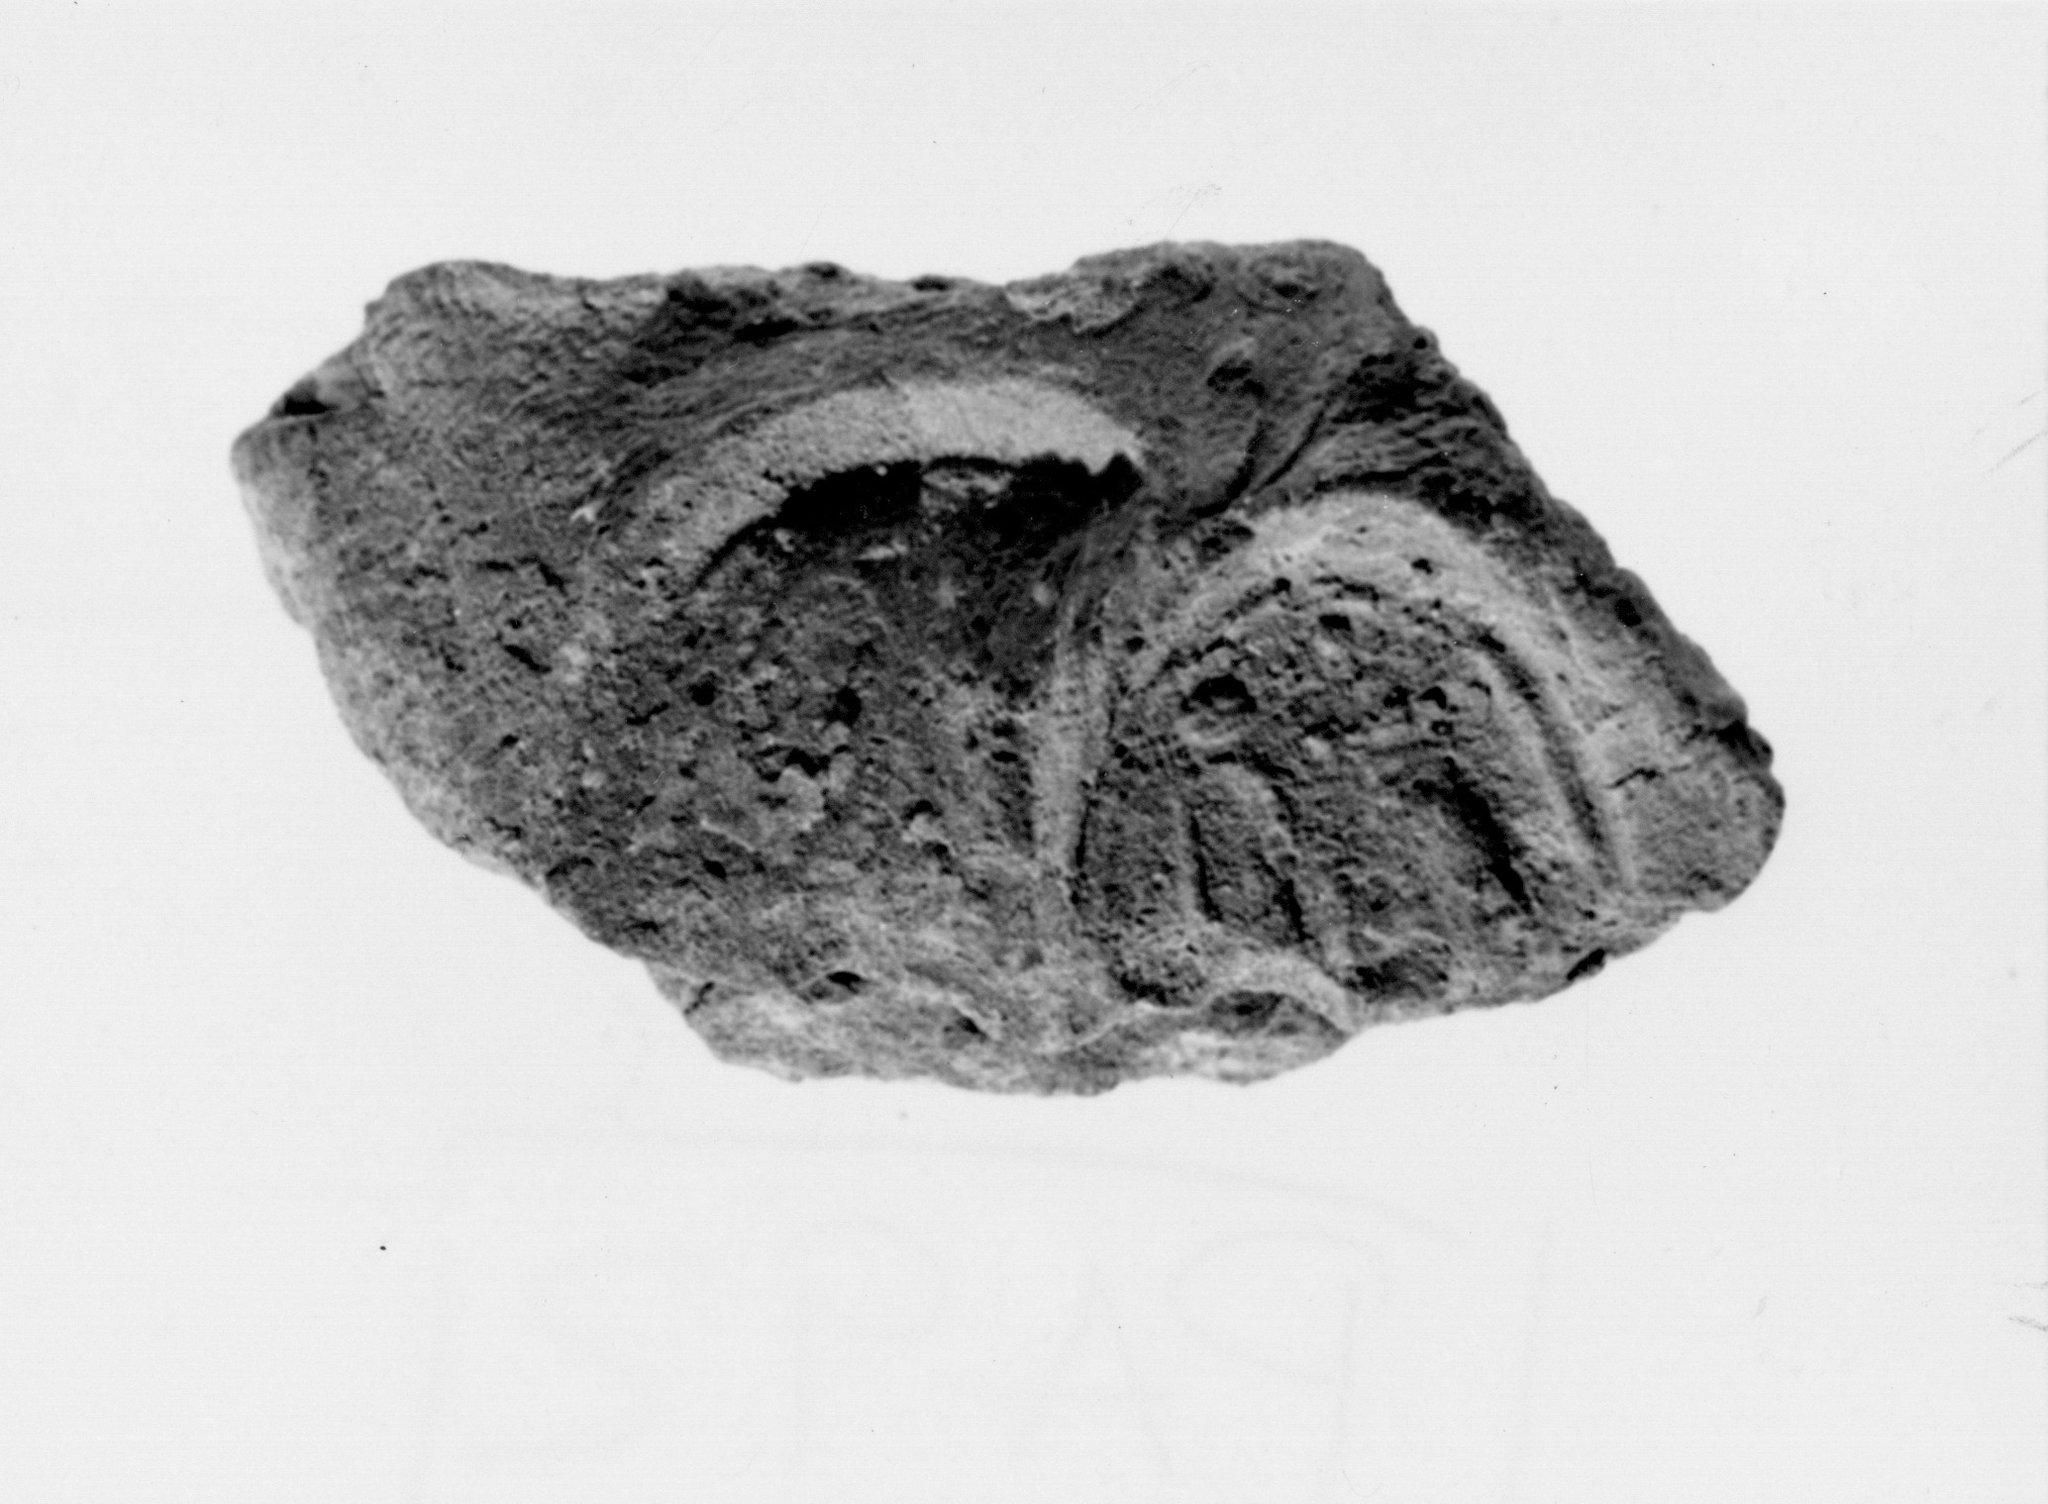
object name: sealing, nebmaatre, amenhotep iii,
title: Document Sealing With the Throne Name of Amenhotep III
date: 1390-1352 BCE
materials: mud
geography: egypt